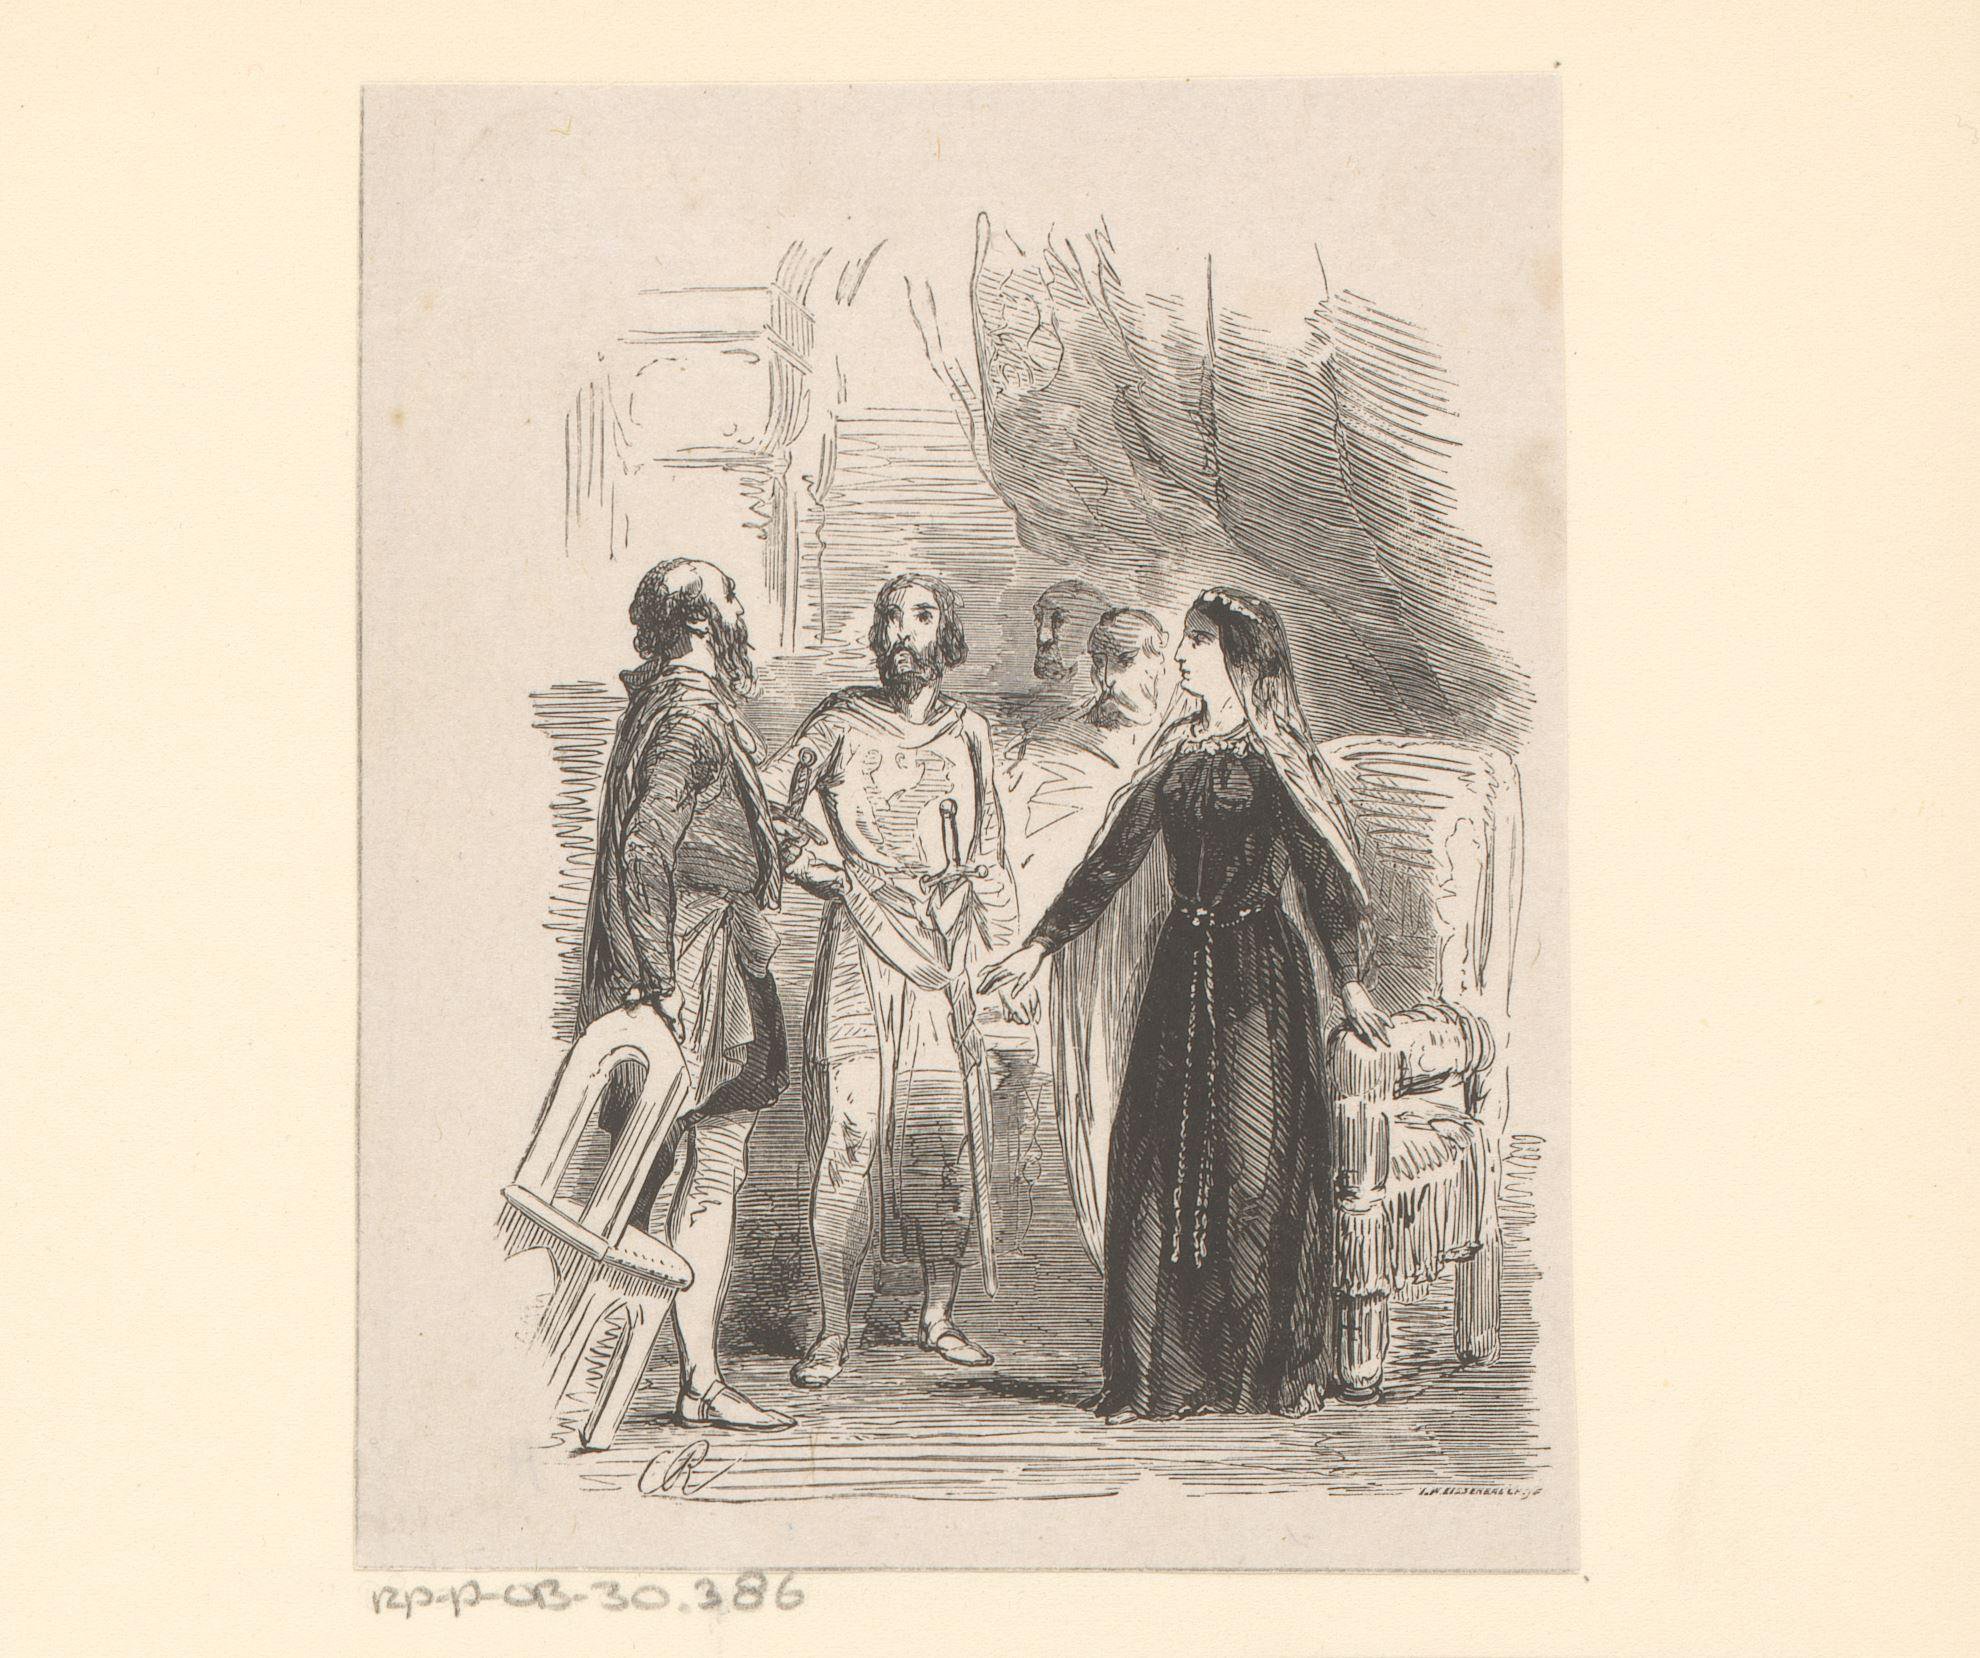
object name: print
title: Twee mannen met zwaarden en een vrouw met een sluier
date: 1836-1912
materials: paper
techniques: engraving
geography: netherlands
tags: adult woman (+ standing), adult man (+ standing)